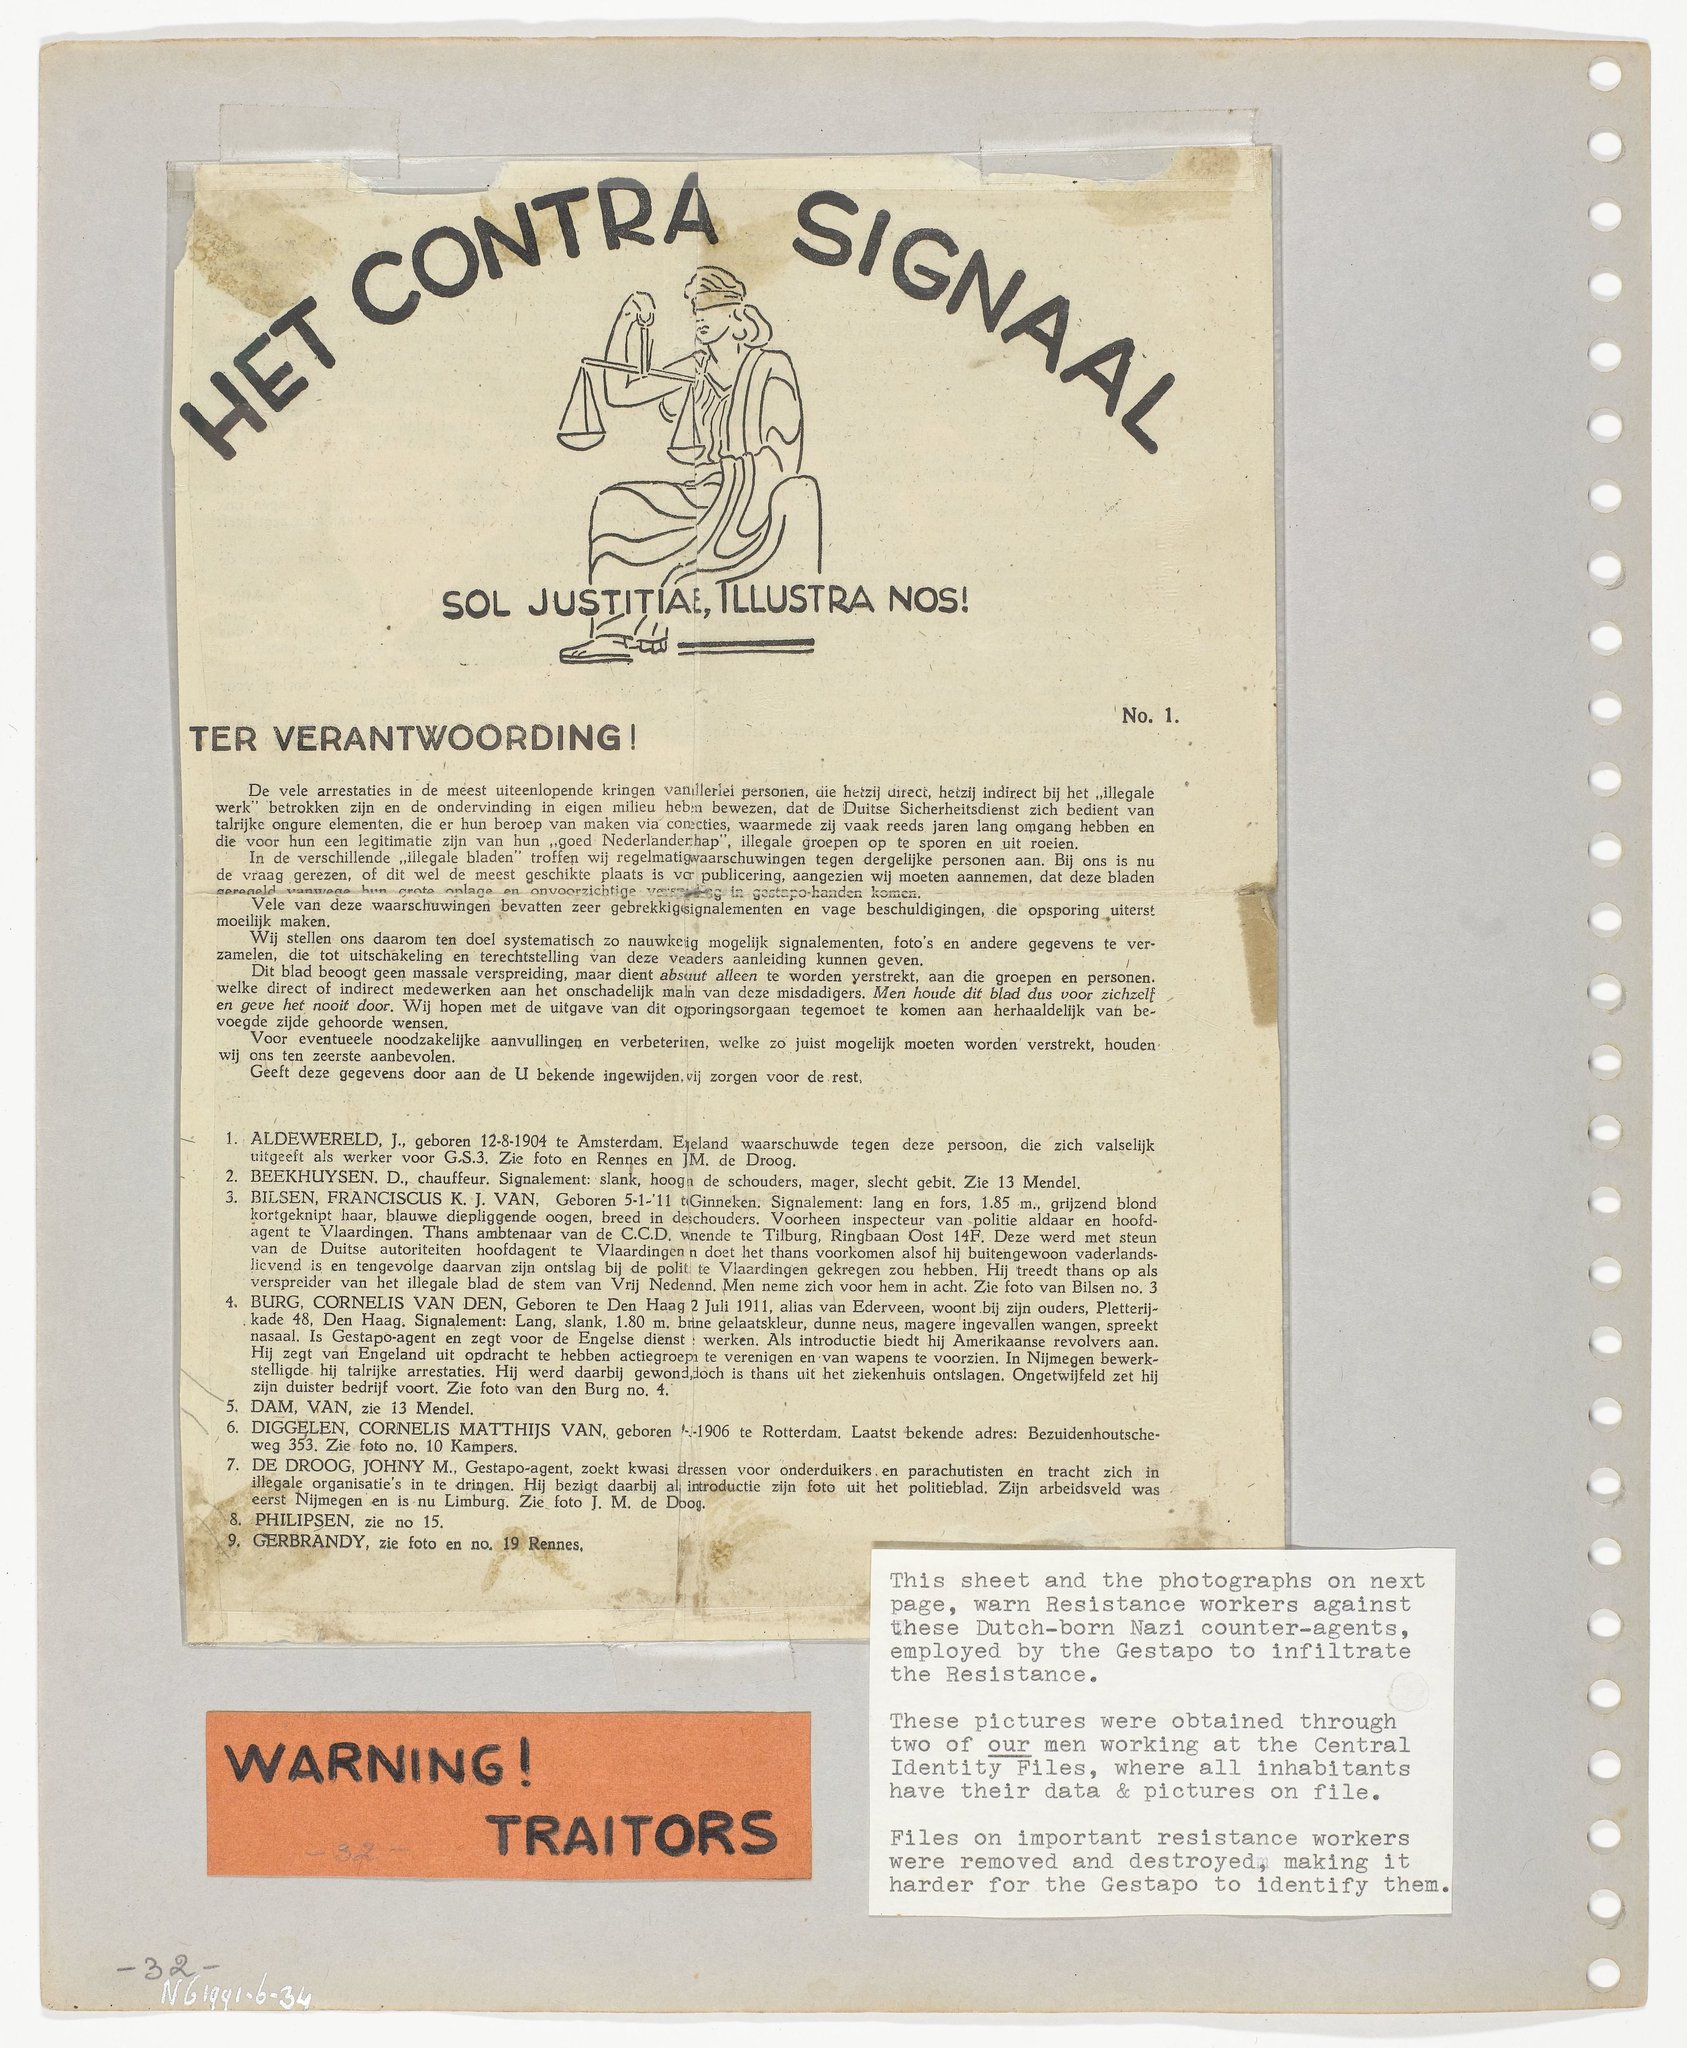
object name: album leaf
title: Waarschuwing tegen infiltranten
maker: Anonymous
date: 1942-1945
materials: paper, plastic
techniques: printing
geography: netherlands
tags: amsterdam, tonny van renterghem, berlin, fritz kahlenberg, underground movement, partisans, netherlands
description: Illegaal blad met waarschuwing tegen personen die zich voordoen als werkend voor het verzet maar in werkelijkheid werken voor de Duitsers.